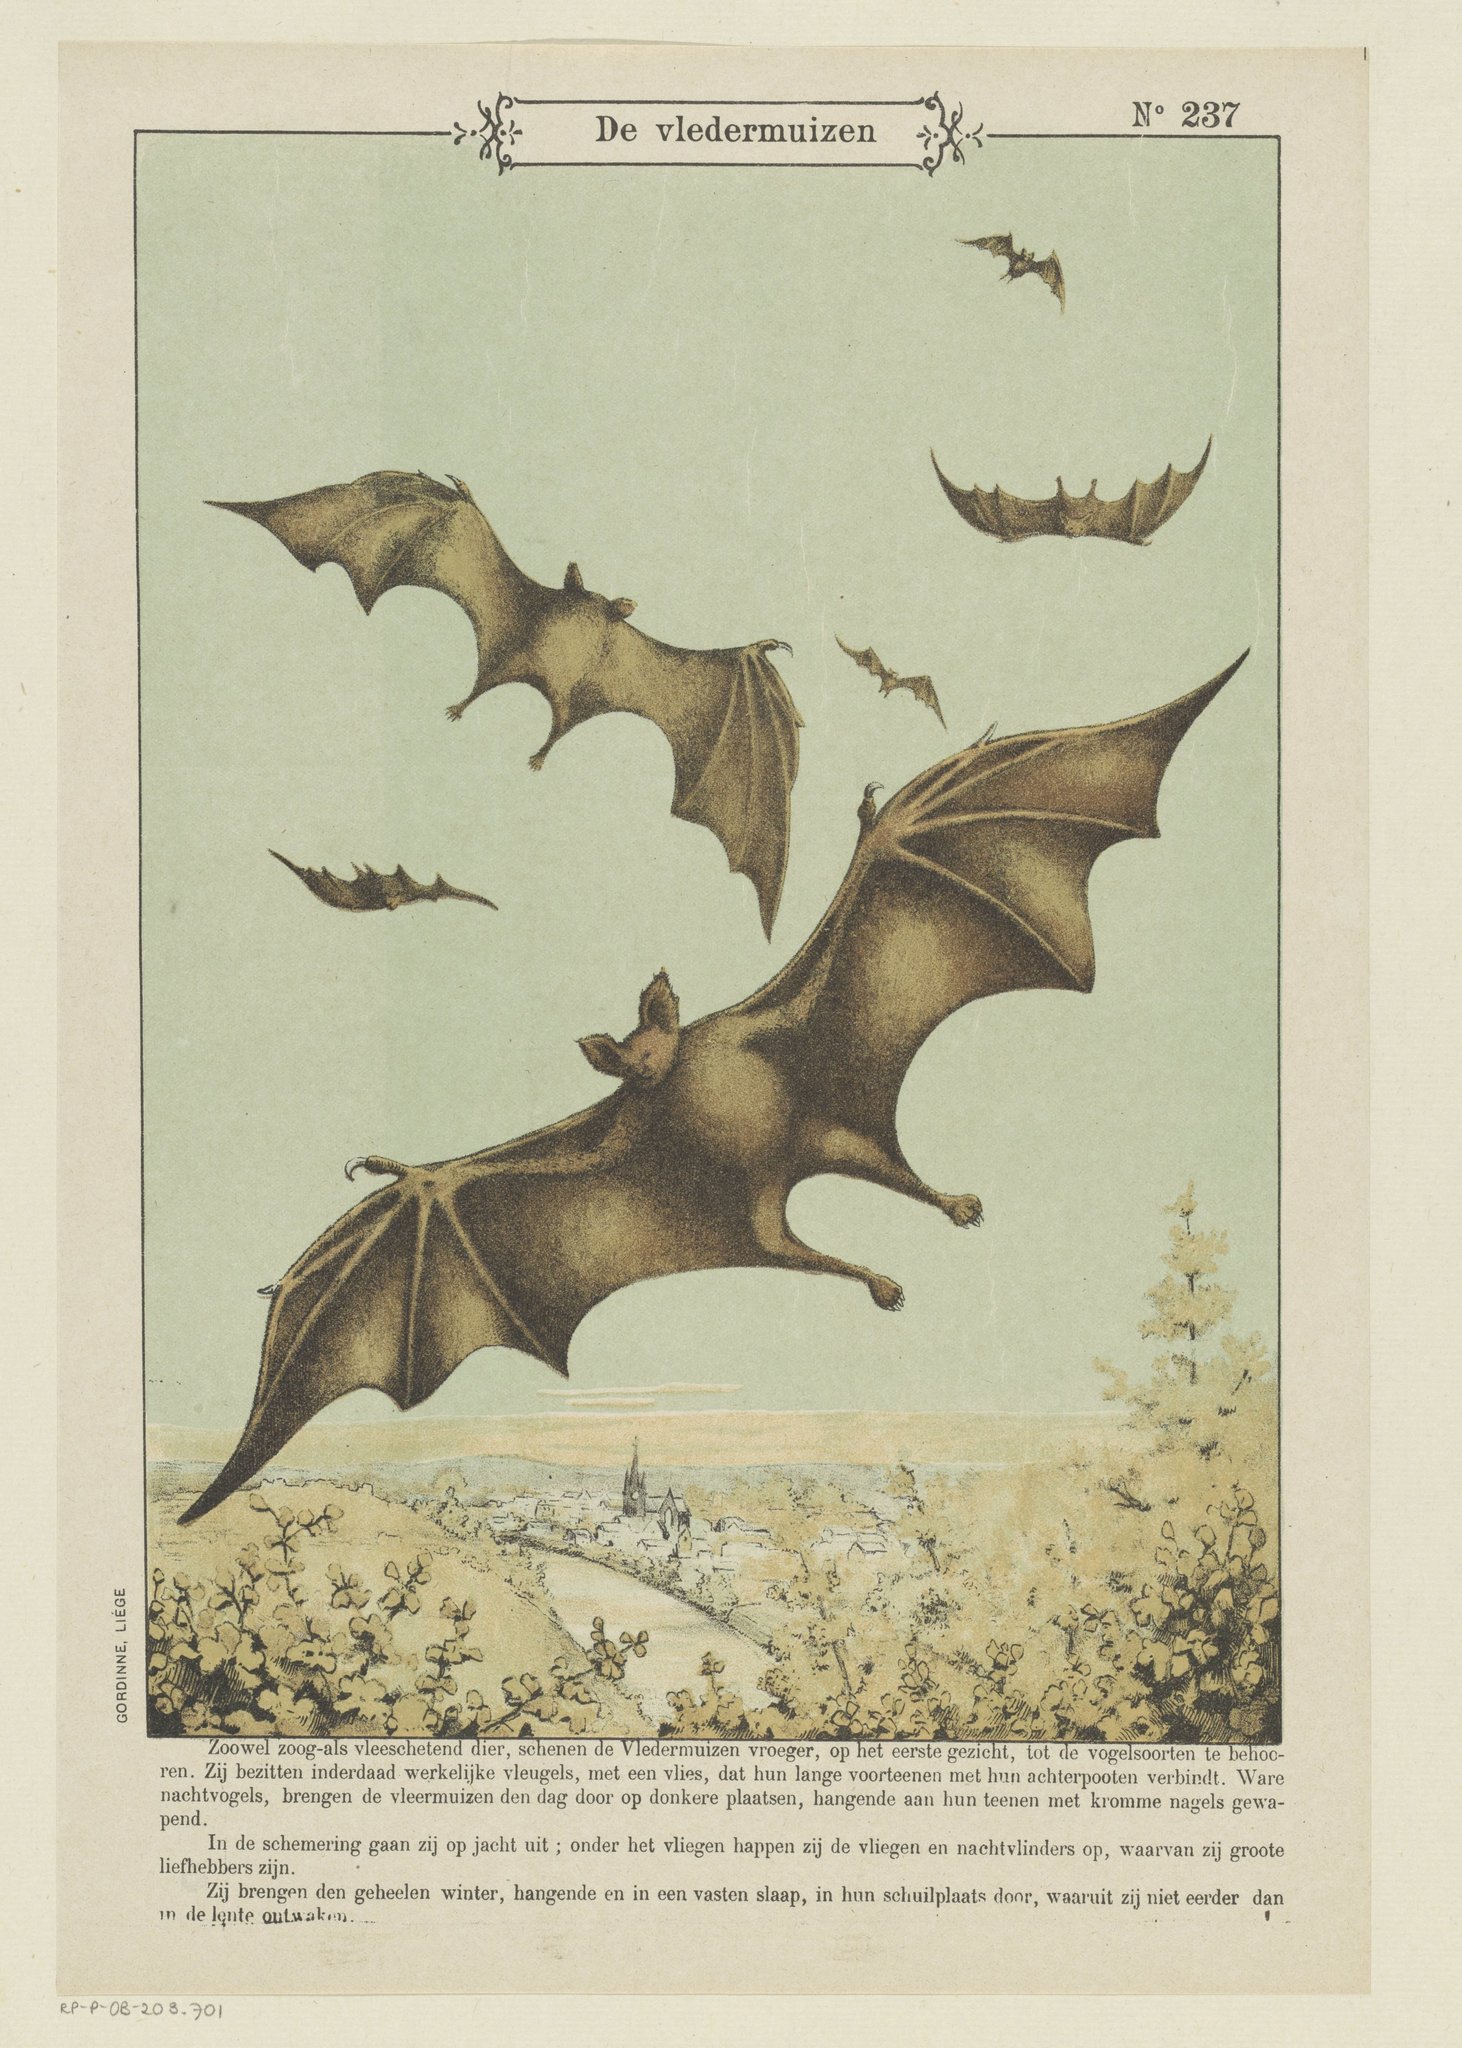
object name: print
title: De vledermuizen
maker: Anonymous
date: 1894-1959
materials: paper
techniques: lithograph, letterpress printing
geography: liège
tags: flying mammals: bat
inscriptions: collector's mark: Lugt 2760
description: Blad met een grote voorstelling van vliegende vleermuizen. In de ondermarge een onderschrift. Genummerd rechtsboven: No 237.